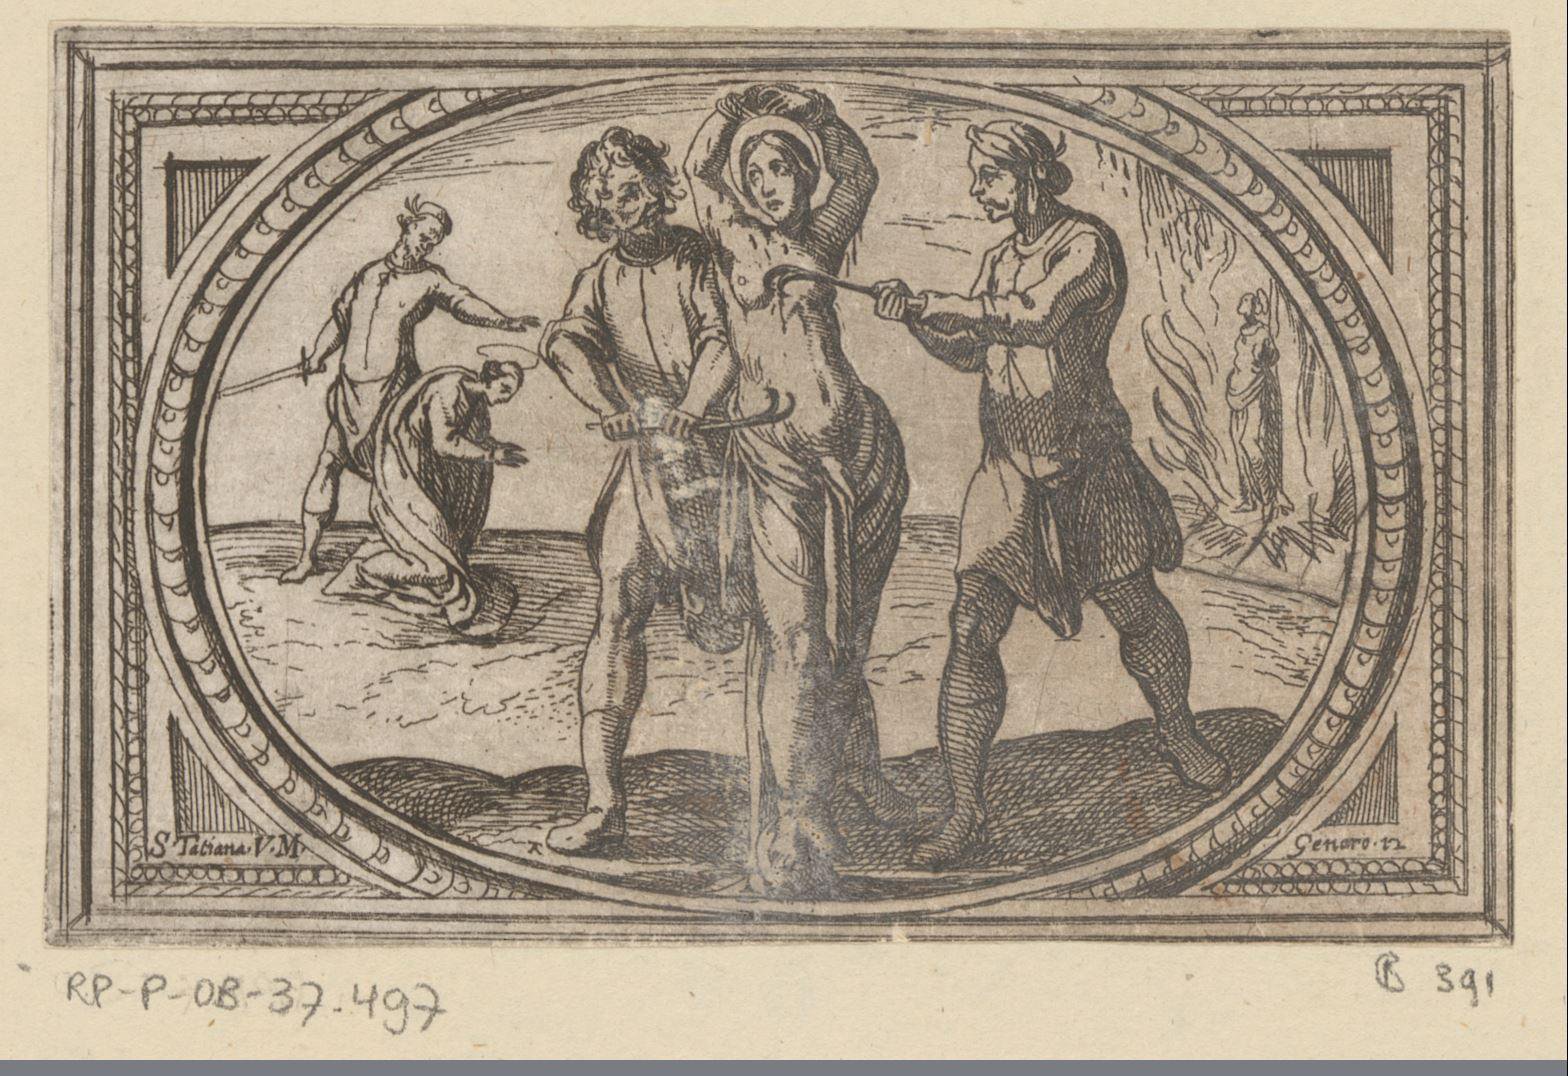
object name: print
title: H. Tatiana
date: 1565-1630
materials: paper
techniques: etching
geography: vatican city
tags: martyr(s) (often with palm-branches) - qq - female martyr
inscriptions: collector's mark: Lugt 240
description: Deze prent maakt deel uit van een reeks van 73 prenten (+ titelprent) met voorstellingen van Romeinse martelaressen.